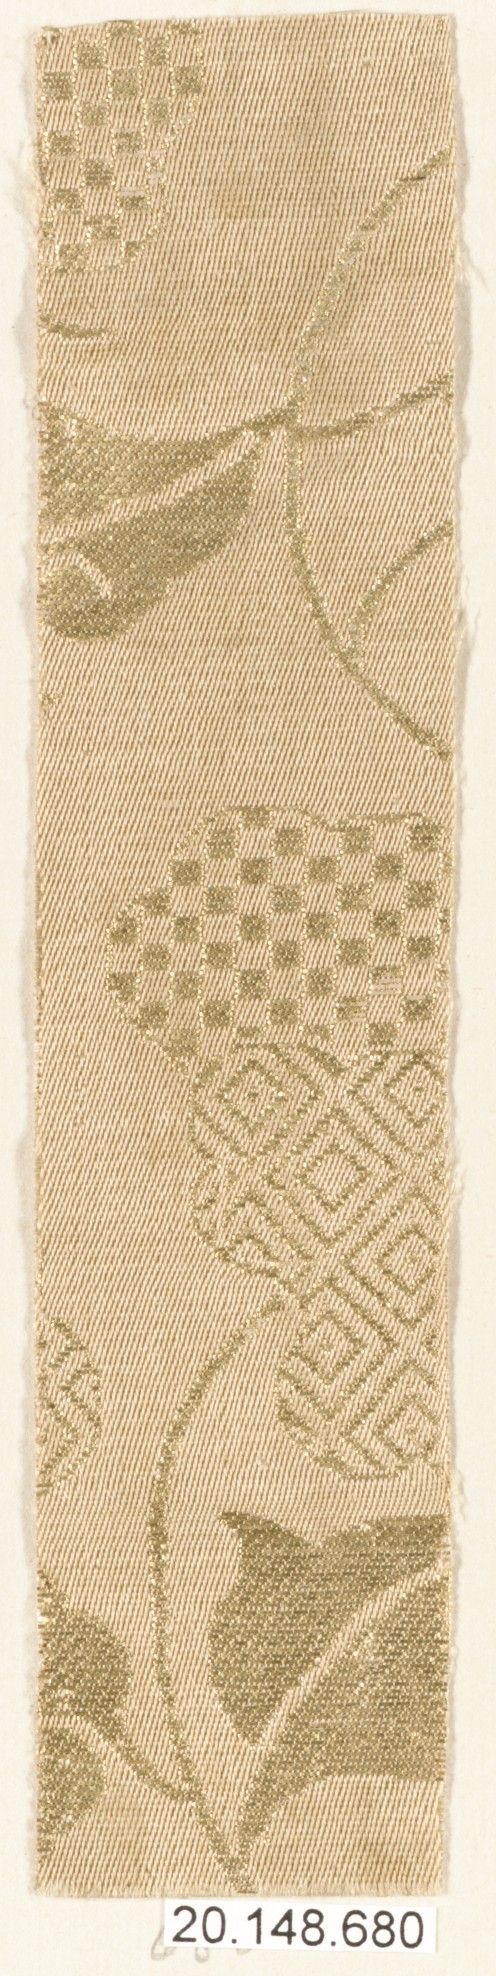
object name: piece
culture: japanese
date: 1701-1800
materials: silk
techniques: compound weave